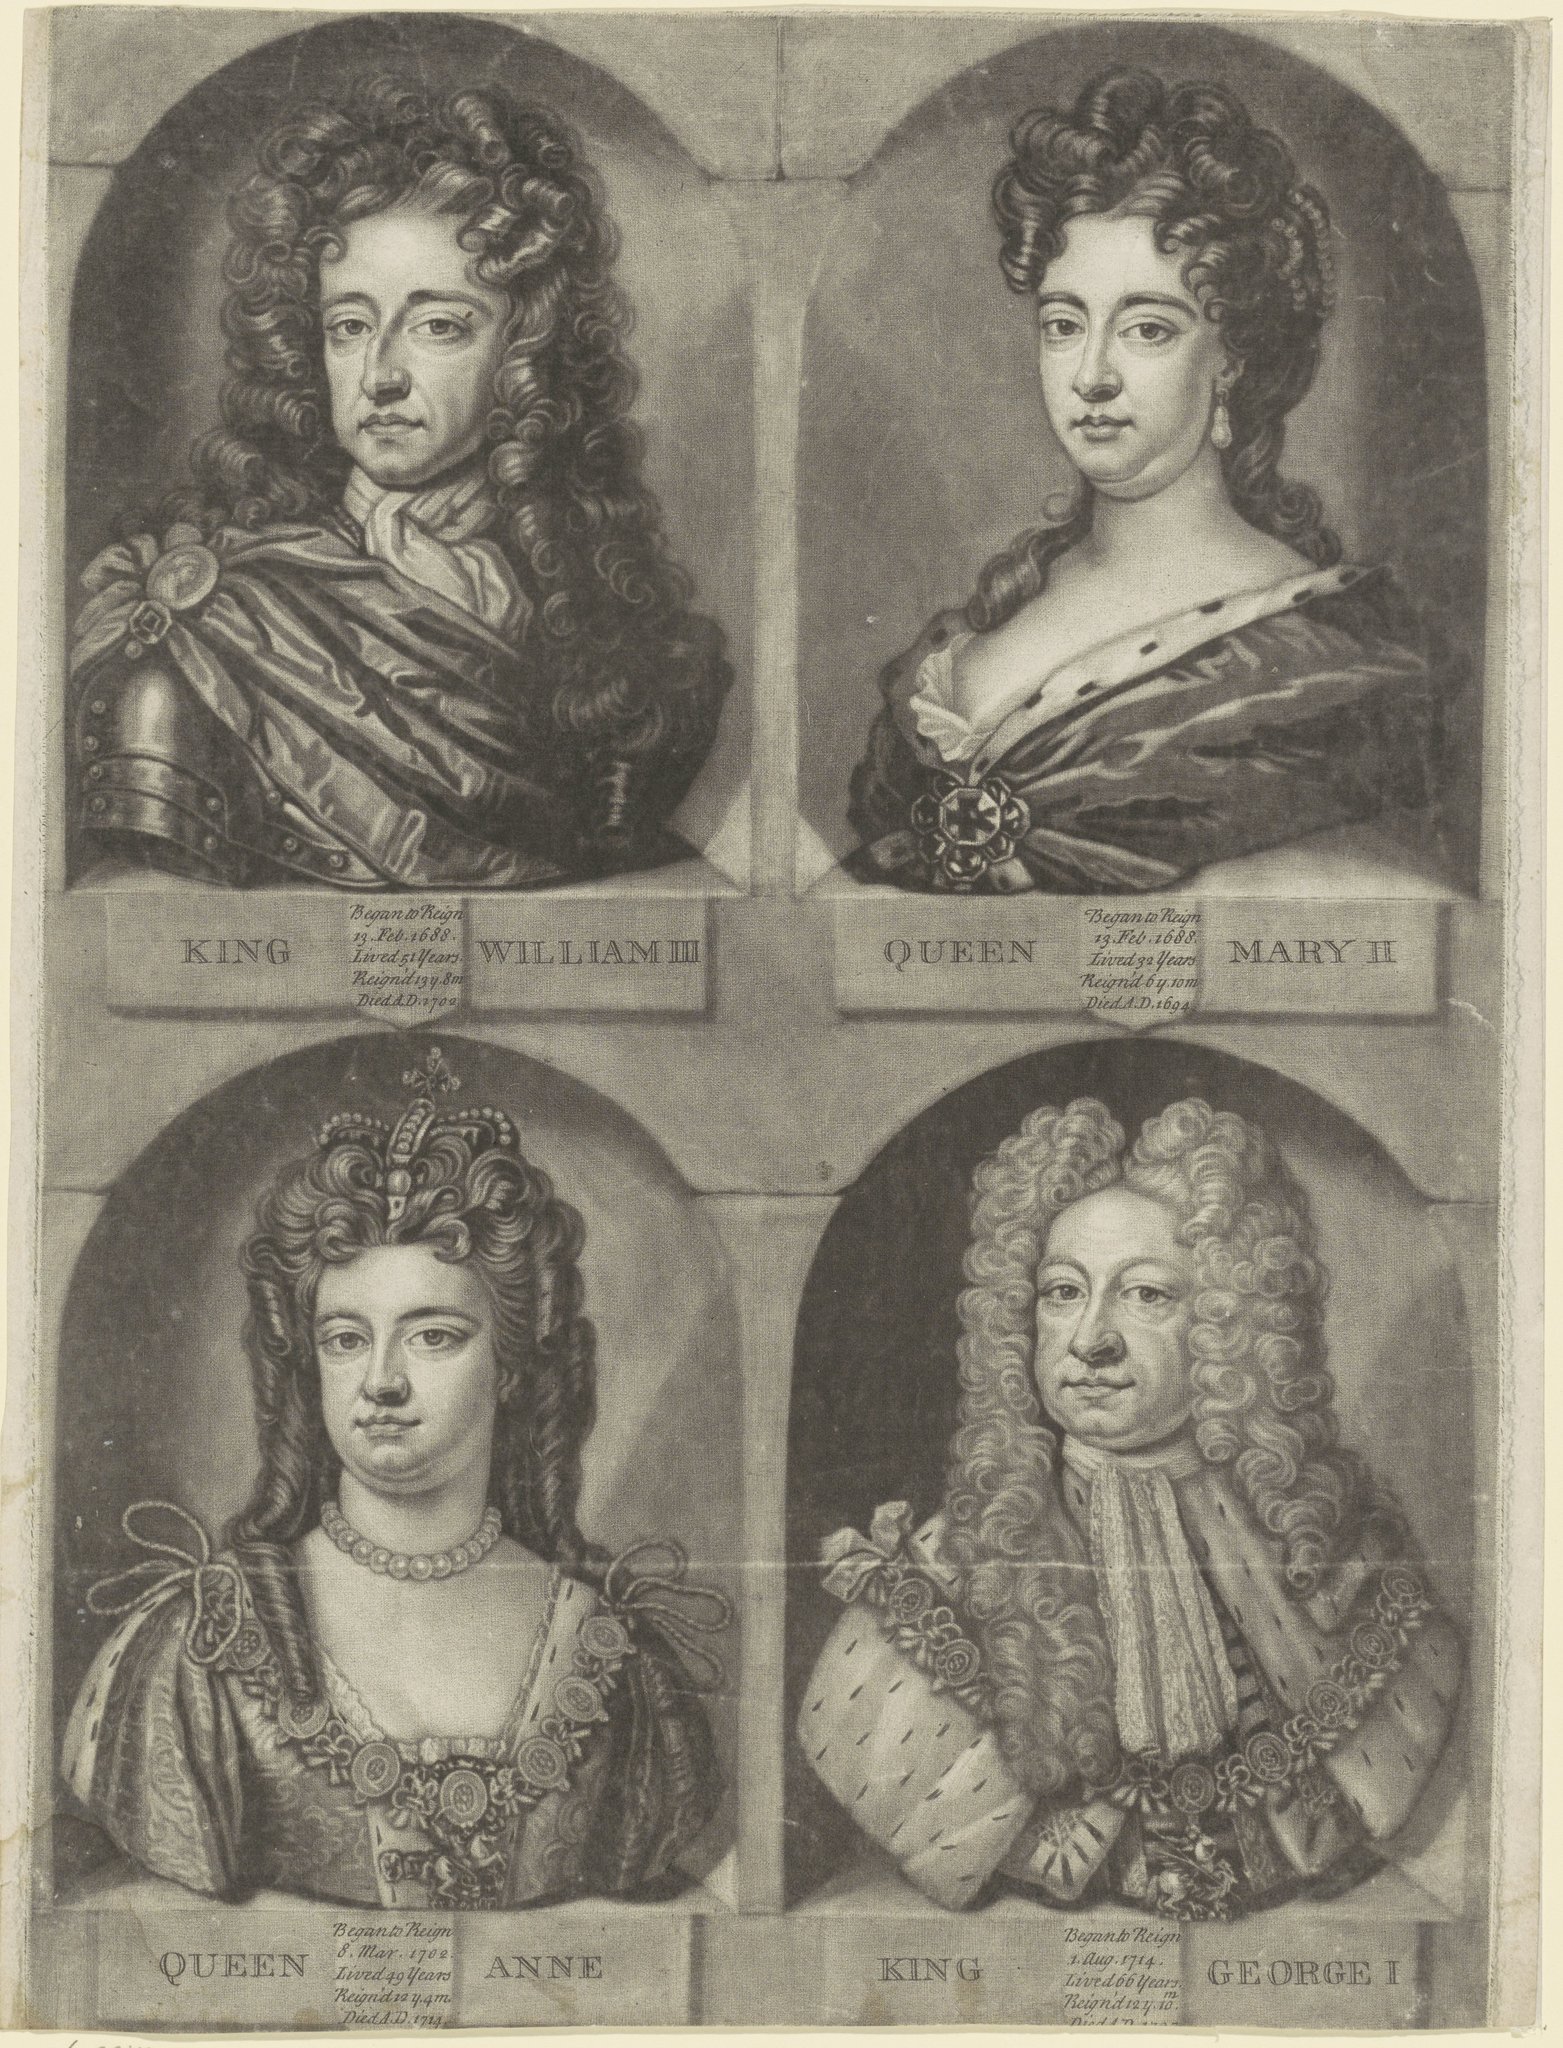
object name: print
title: Portretten van Willem III, prins van Oranje, Maria II Stuart, Anna Stuart en George I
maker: john faber (ii)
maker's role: print maker, publisher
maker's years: 1684-1756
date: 1699-1756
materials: paper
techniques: mezzotint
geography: london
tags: the hague, william iii (prince of orange and king of england, scotland, and ireland), maria ii stuart (koningin van engeland, schotland en ierland), anna stuart (koningin van engeland en schotland), george i (koning van groot-brittannië en ierland)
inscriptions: collector's mark: Lugt 2228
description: Portret van Willem III onder een toog linksboven en portret van Maria II onder een toog rechtsboven. Portret van Anna Stuart in een toog linksonder en portret van George I in een toog rechtsonder.